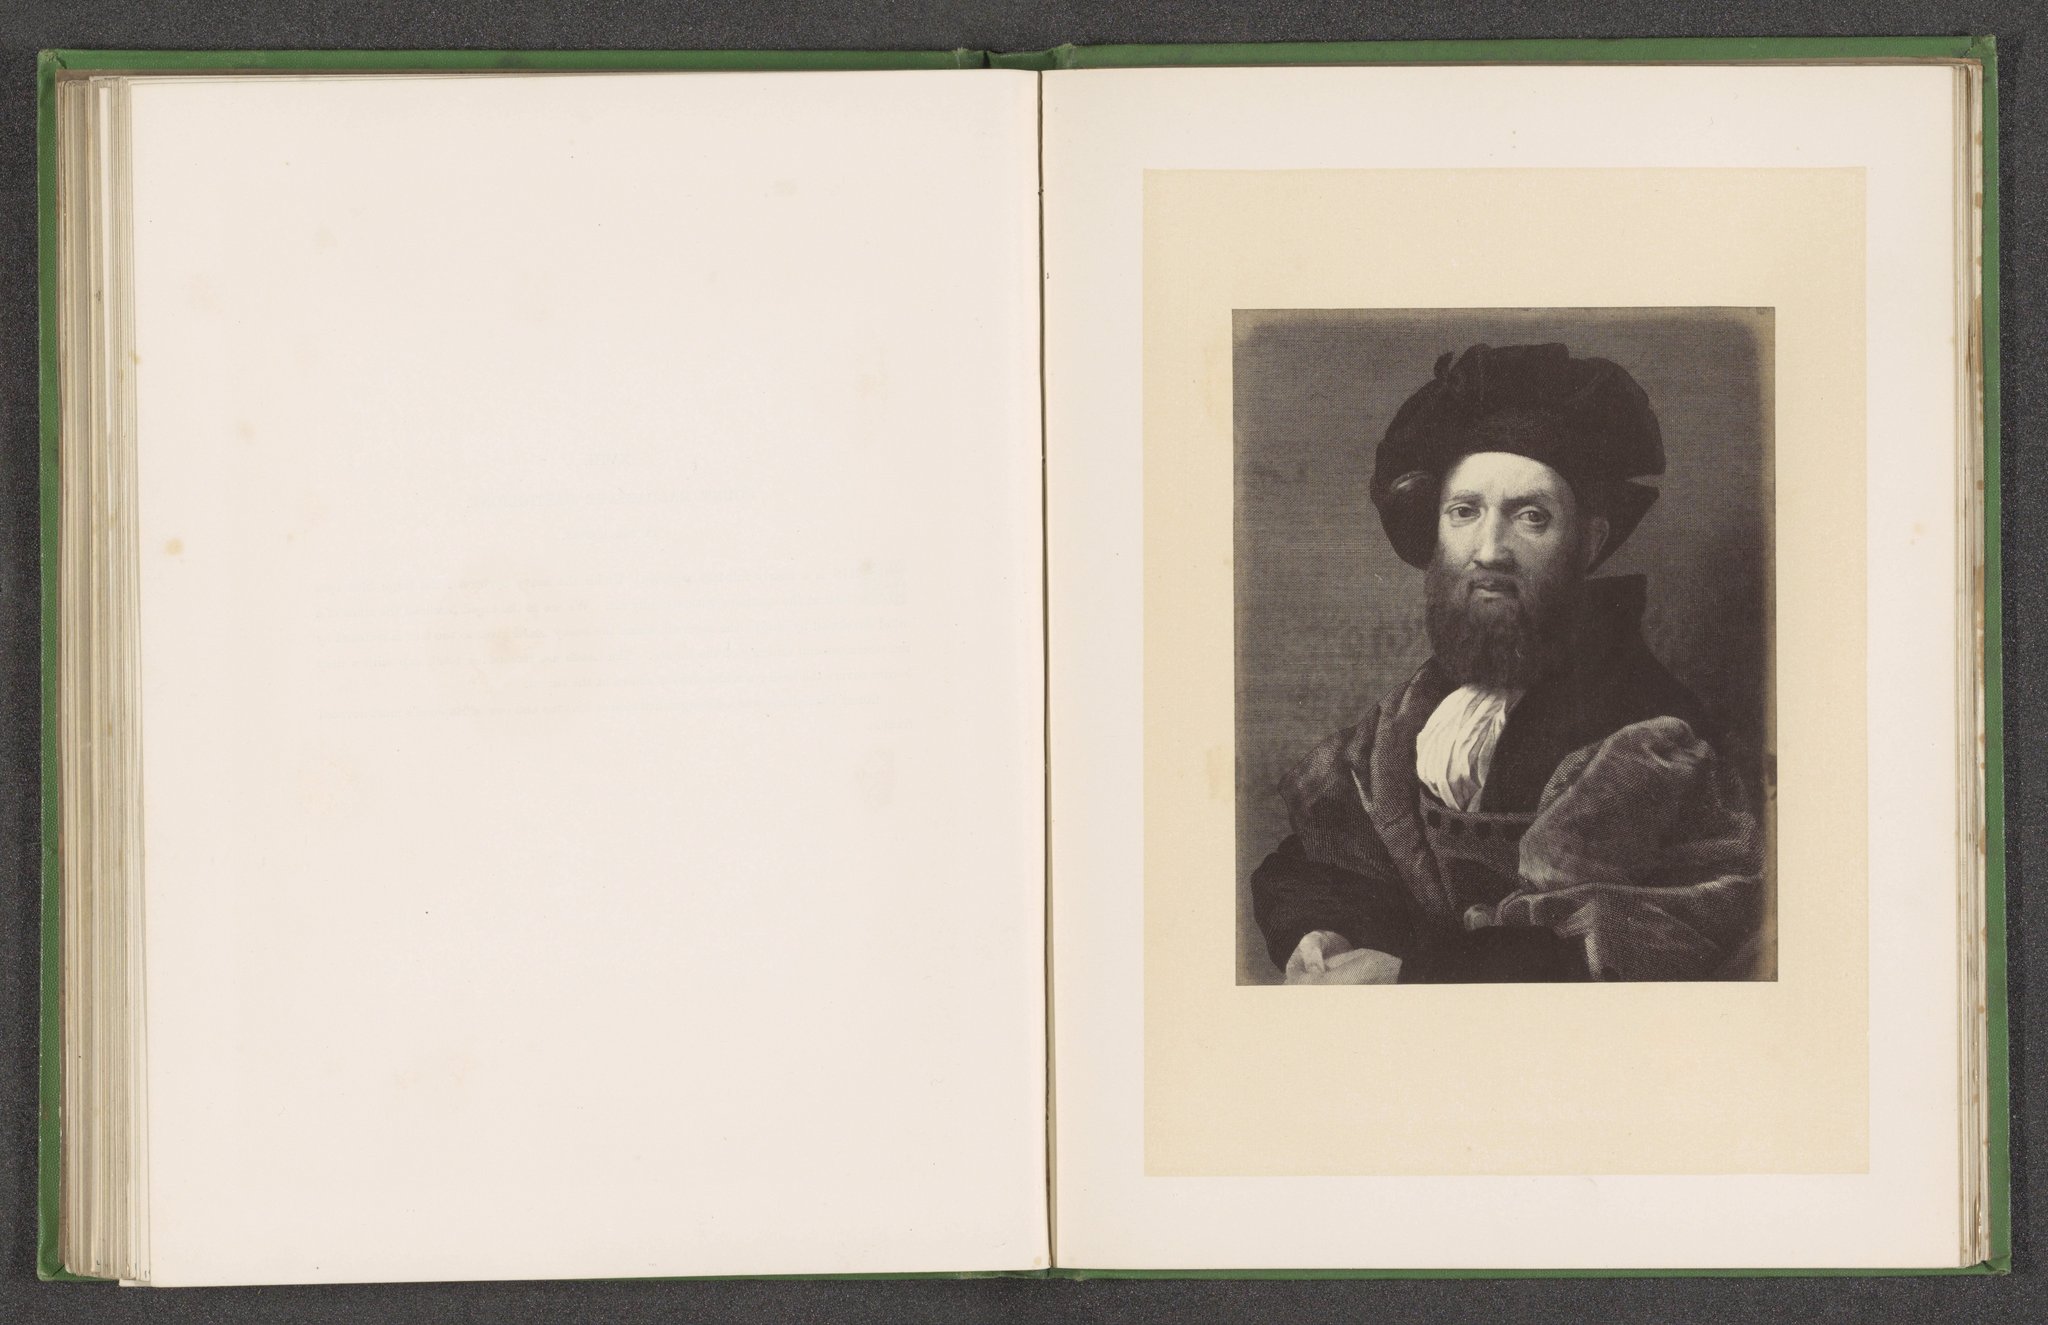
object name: page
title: Fotoreproductie van een prent door Edelinck van een portret van Baldassarre Castiglione door Rafaël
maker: joseph cundall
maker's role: fotograaf, schrijver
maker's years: 1818-1895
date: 1859-1869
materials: photographic support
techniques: albumen print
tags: diplomacy, diplomat